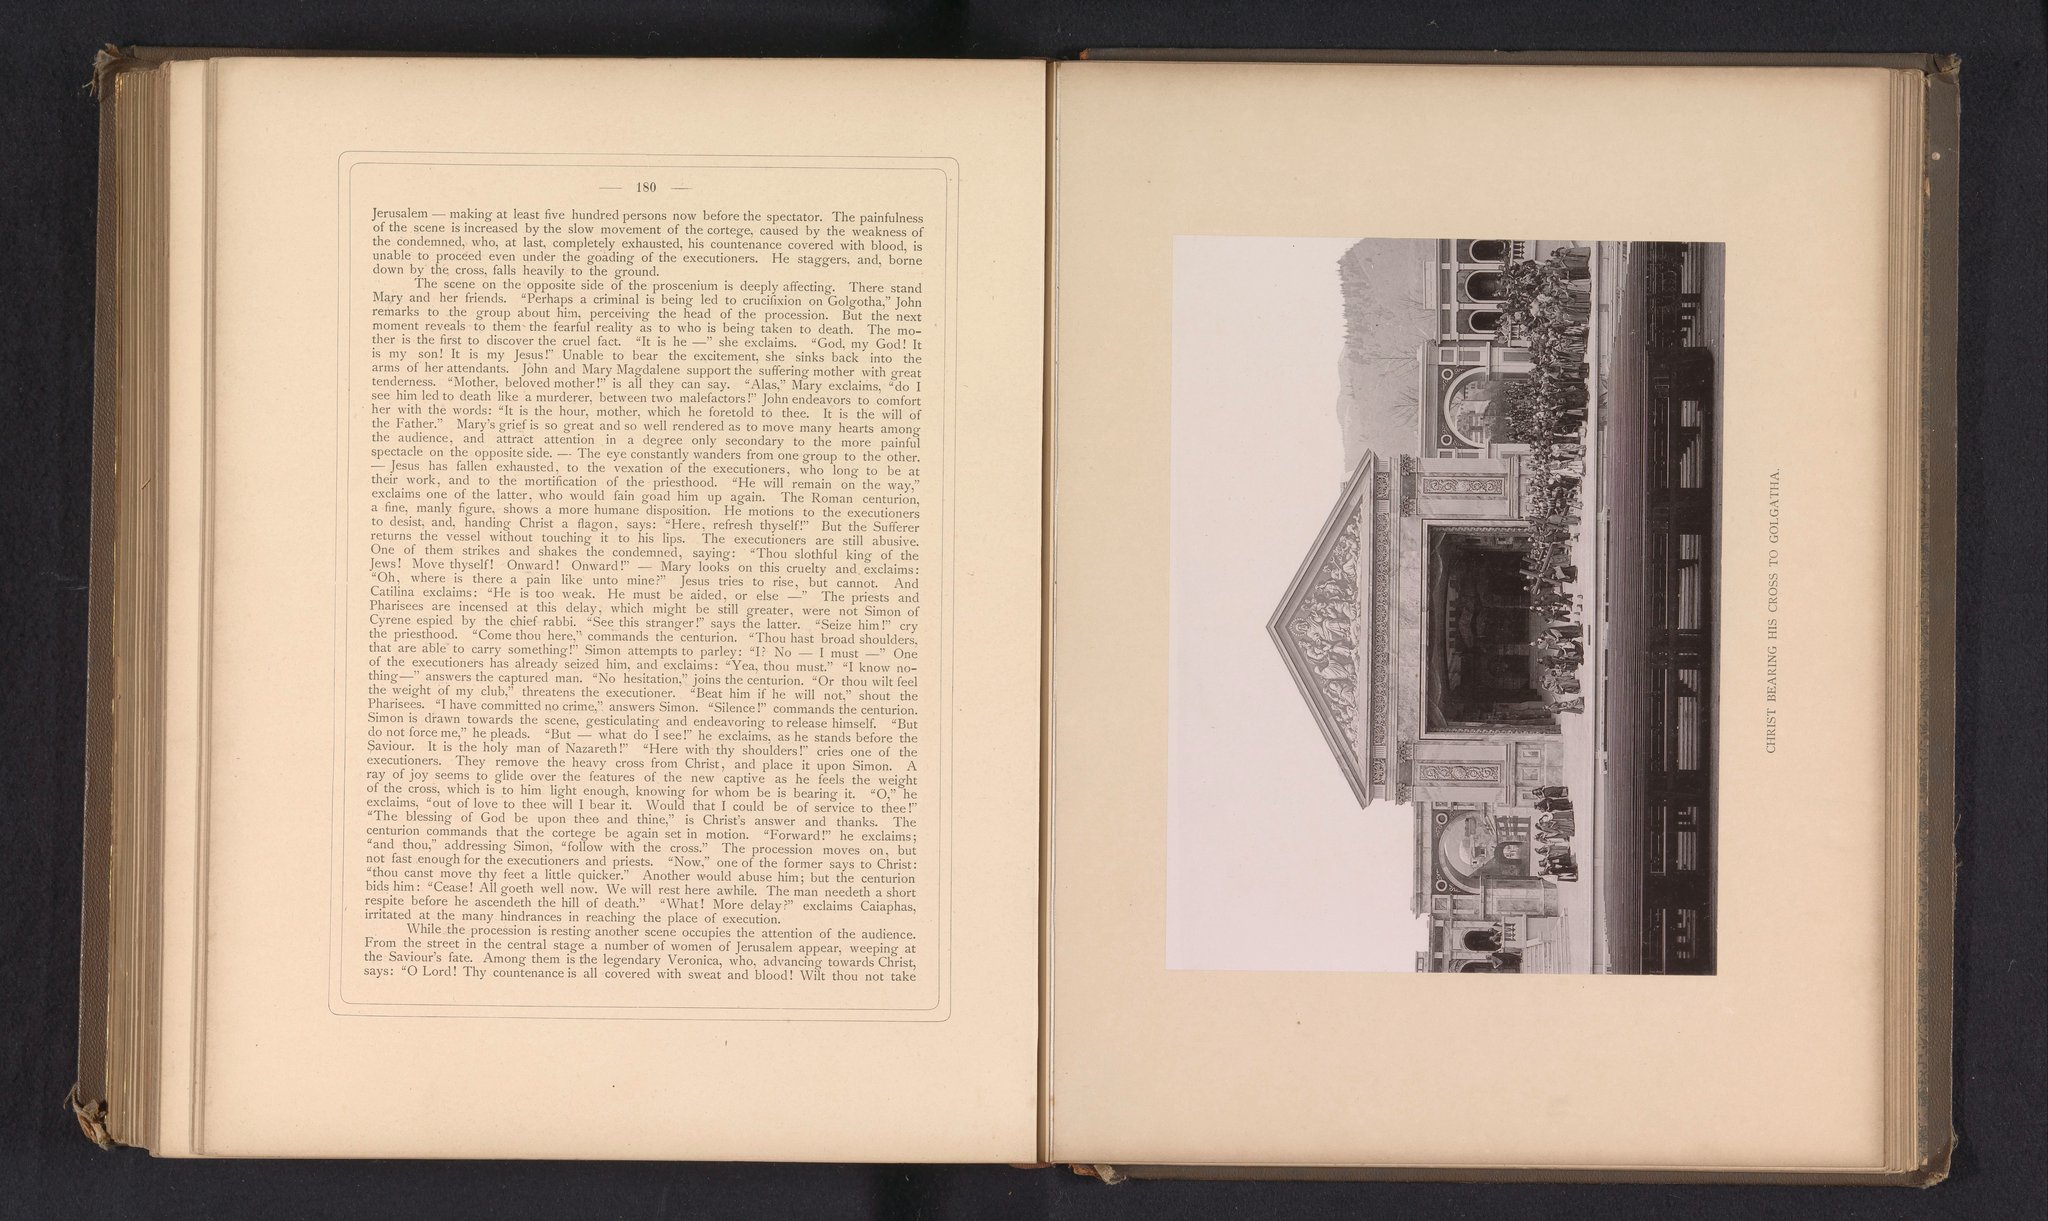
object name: photomechanical print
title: Christ bearing his cross to Golgatha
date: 1885-1890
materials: paper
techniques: photograph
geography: oberammergau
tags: group of actors, troupe; actors on the stage, from pilate's palace to golgotha: the procession to calvary (matthew 27:31-33; mark 15:20-22; luke 23:26-33; john 19:17)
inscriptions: inscription: ‘Gemeinde Oberammergau Passionsspiel 1890’